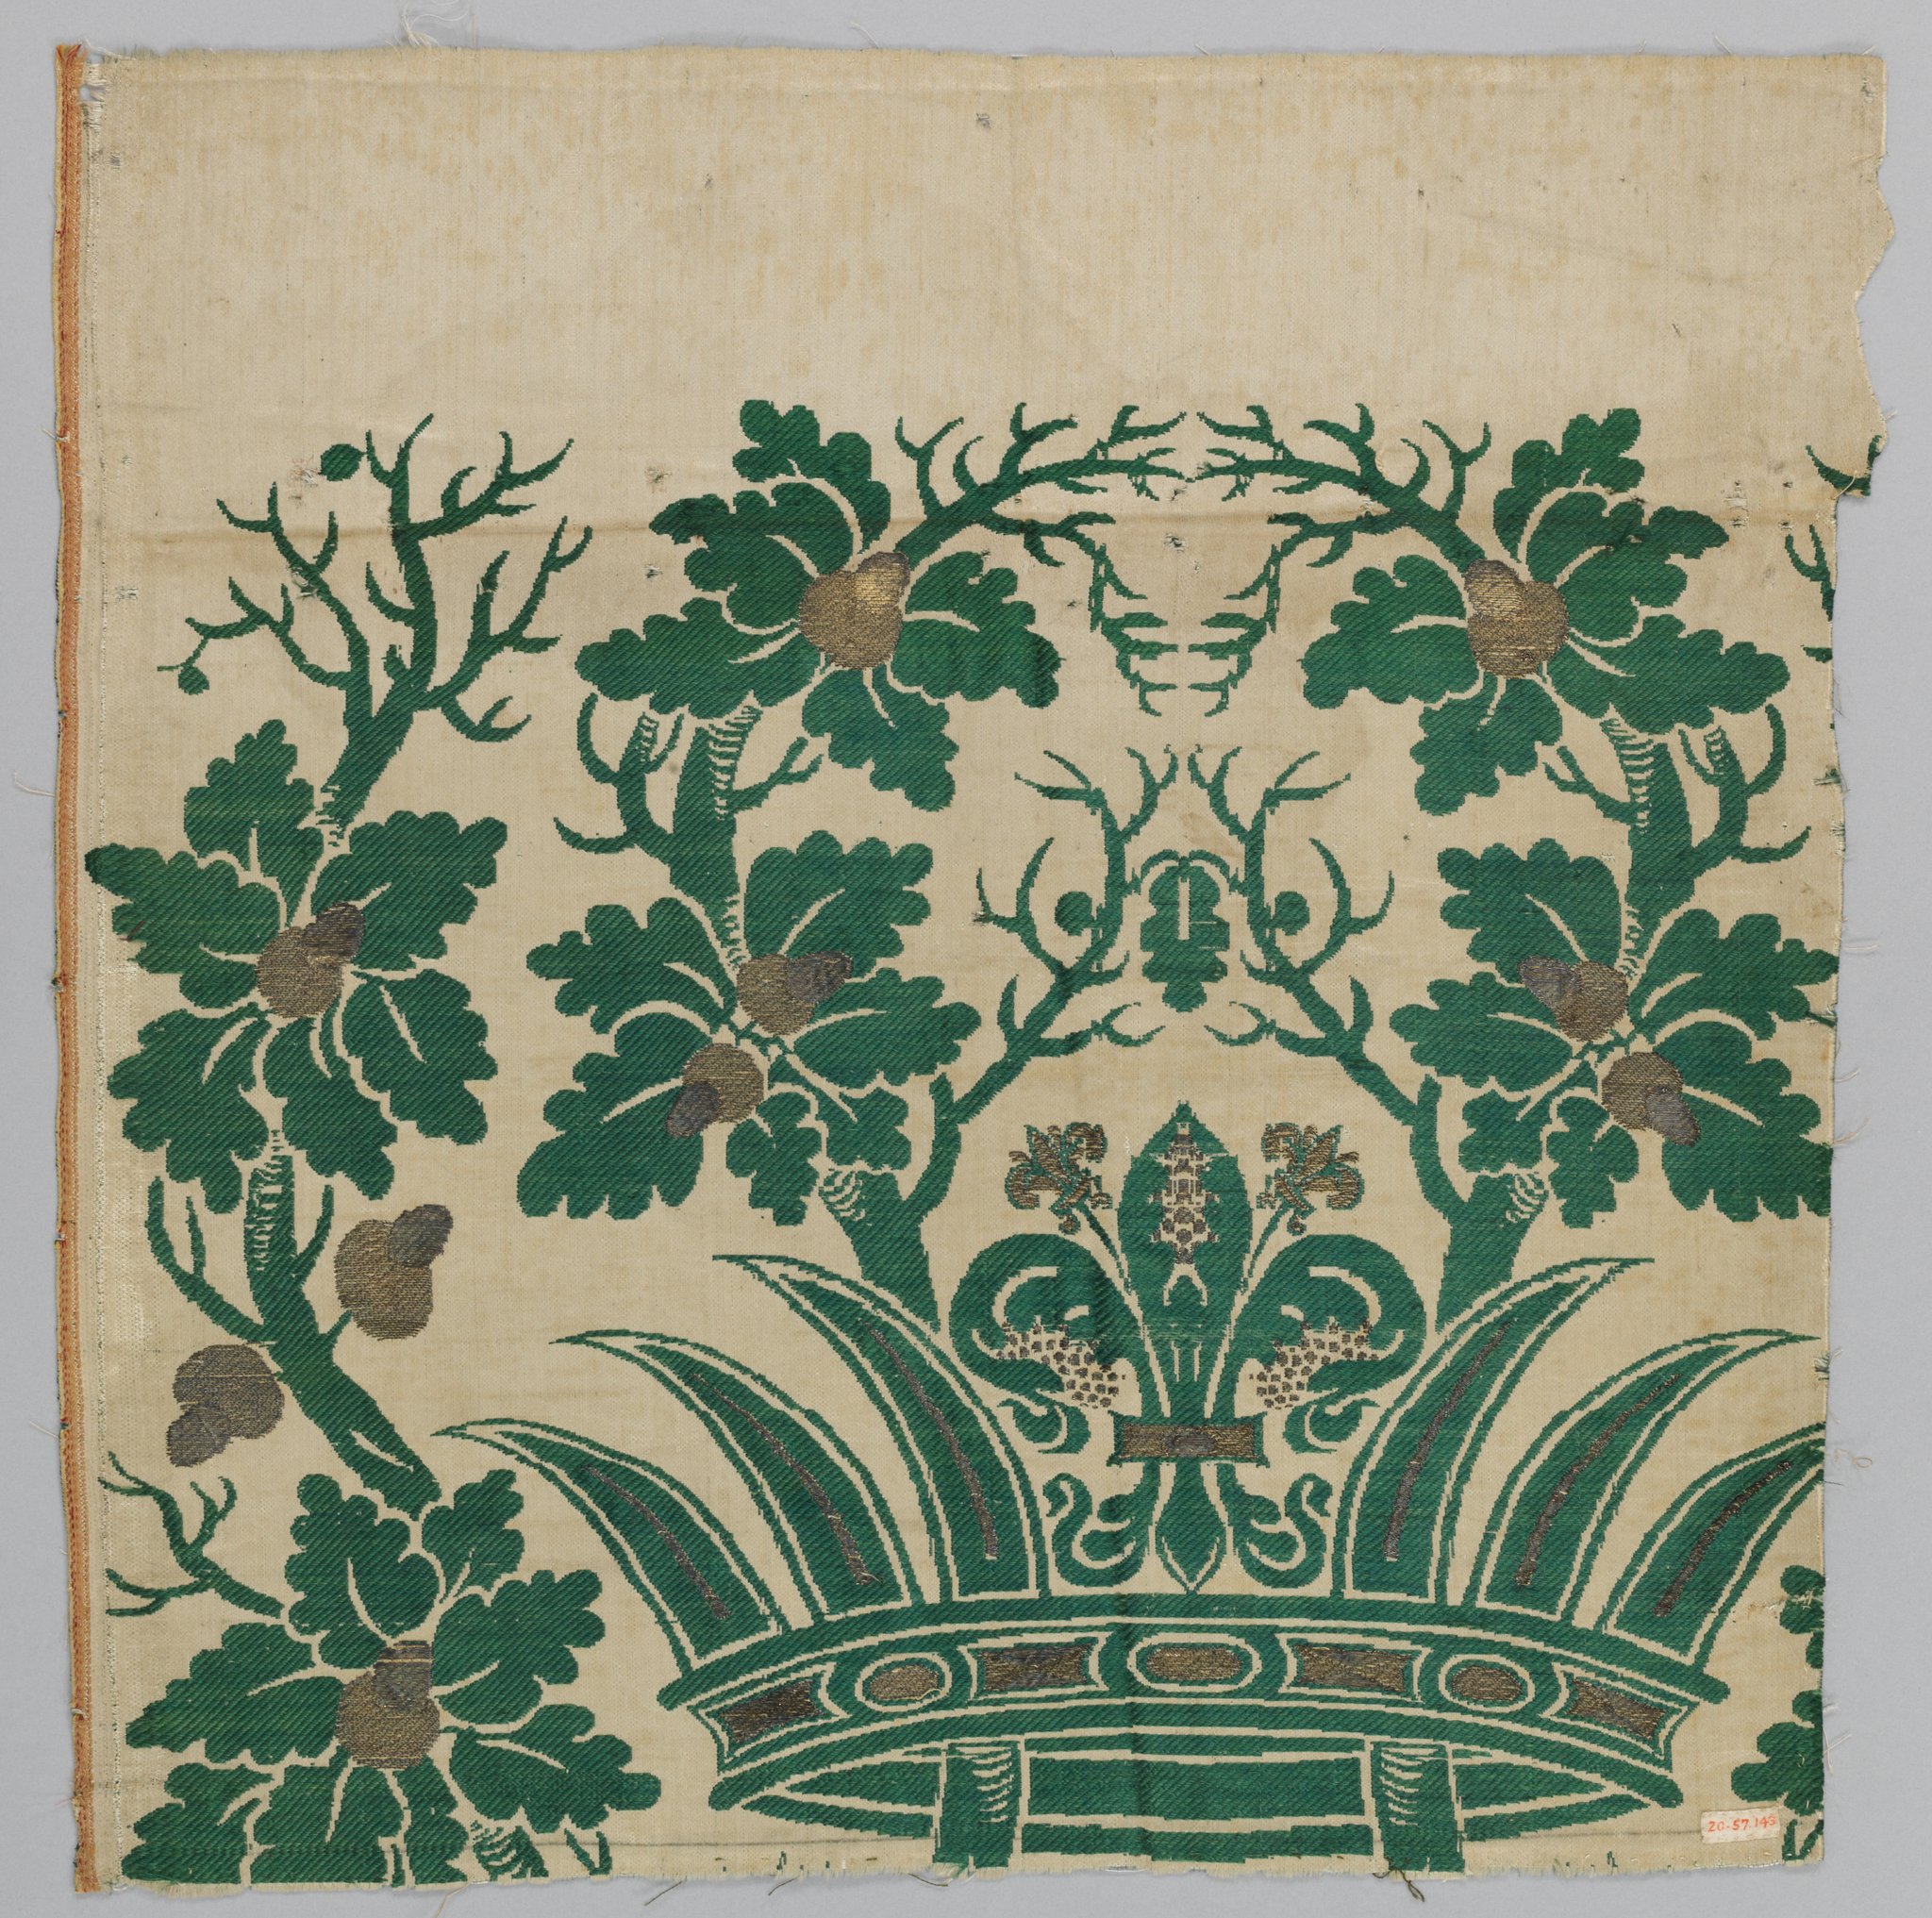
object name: piece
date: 1601-1700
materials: metal thread, silk